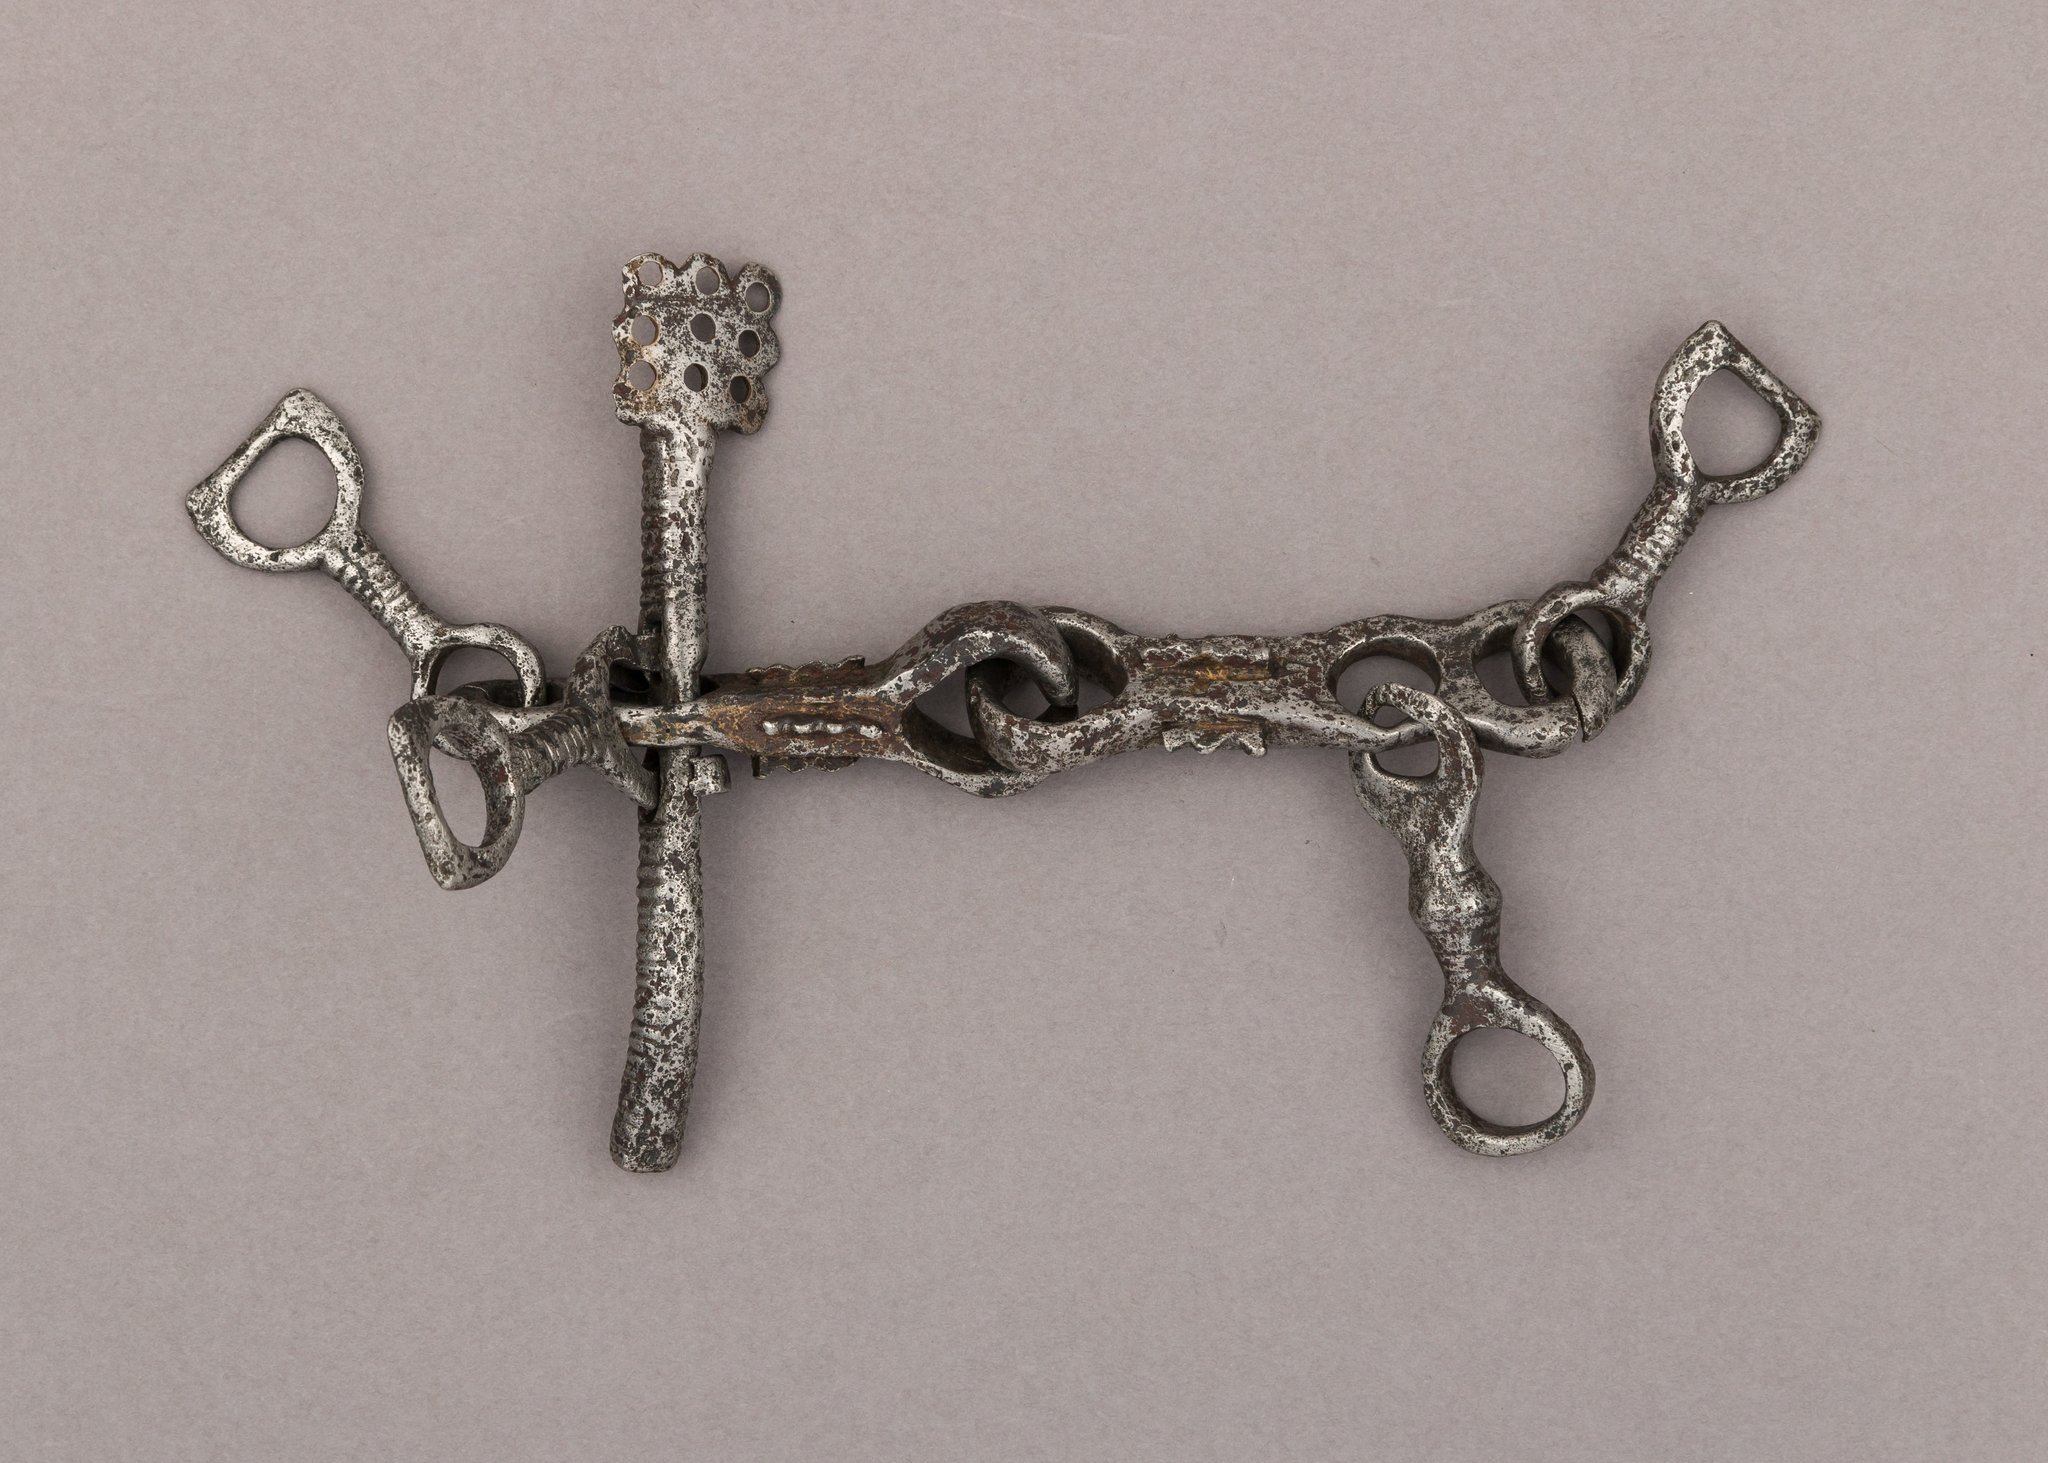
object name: bit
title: Snaffle Bit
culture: visigothic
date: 601-700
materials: copper, metal alloy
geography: spain